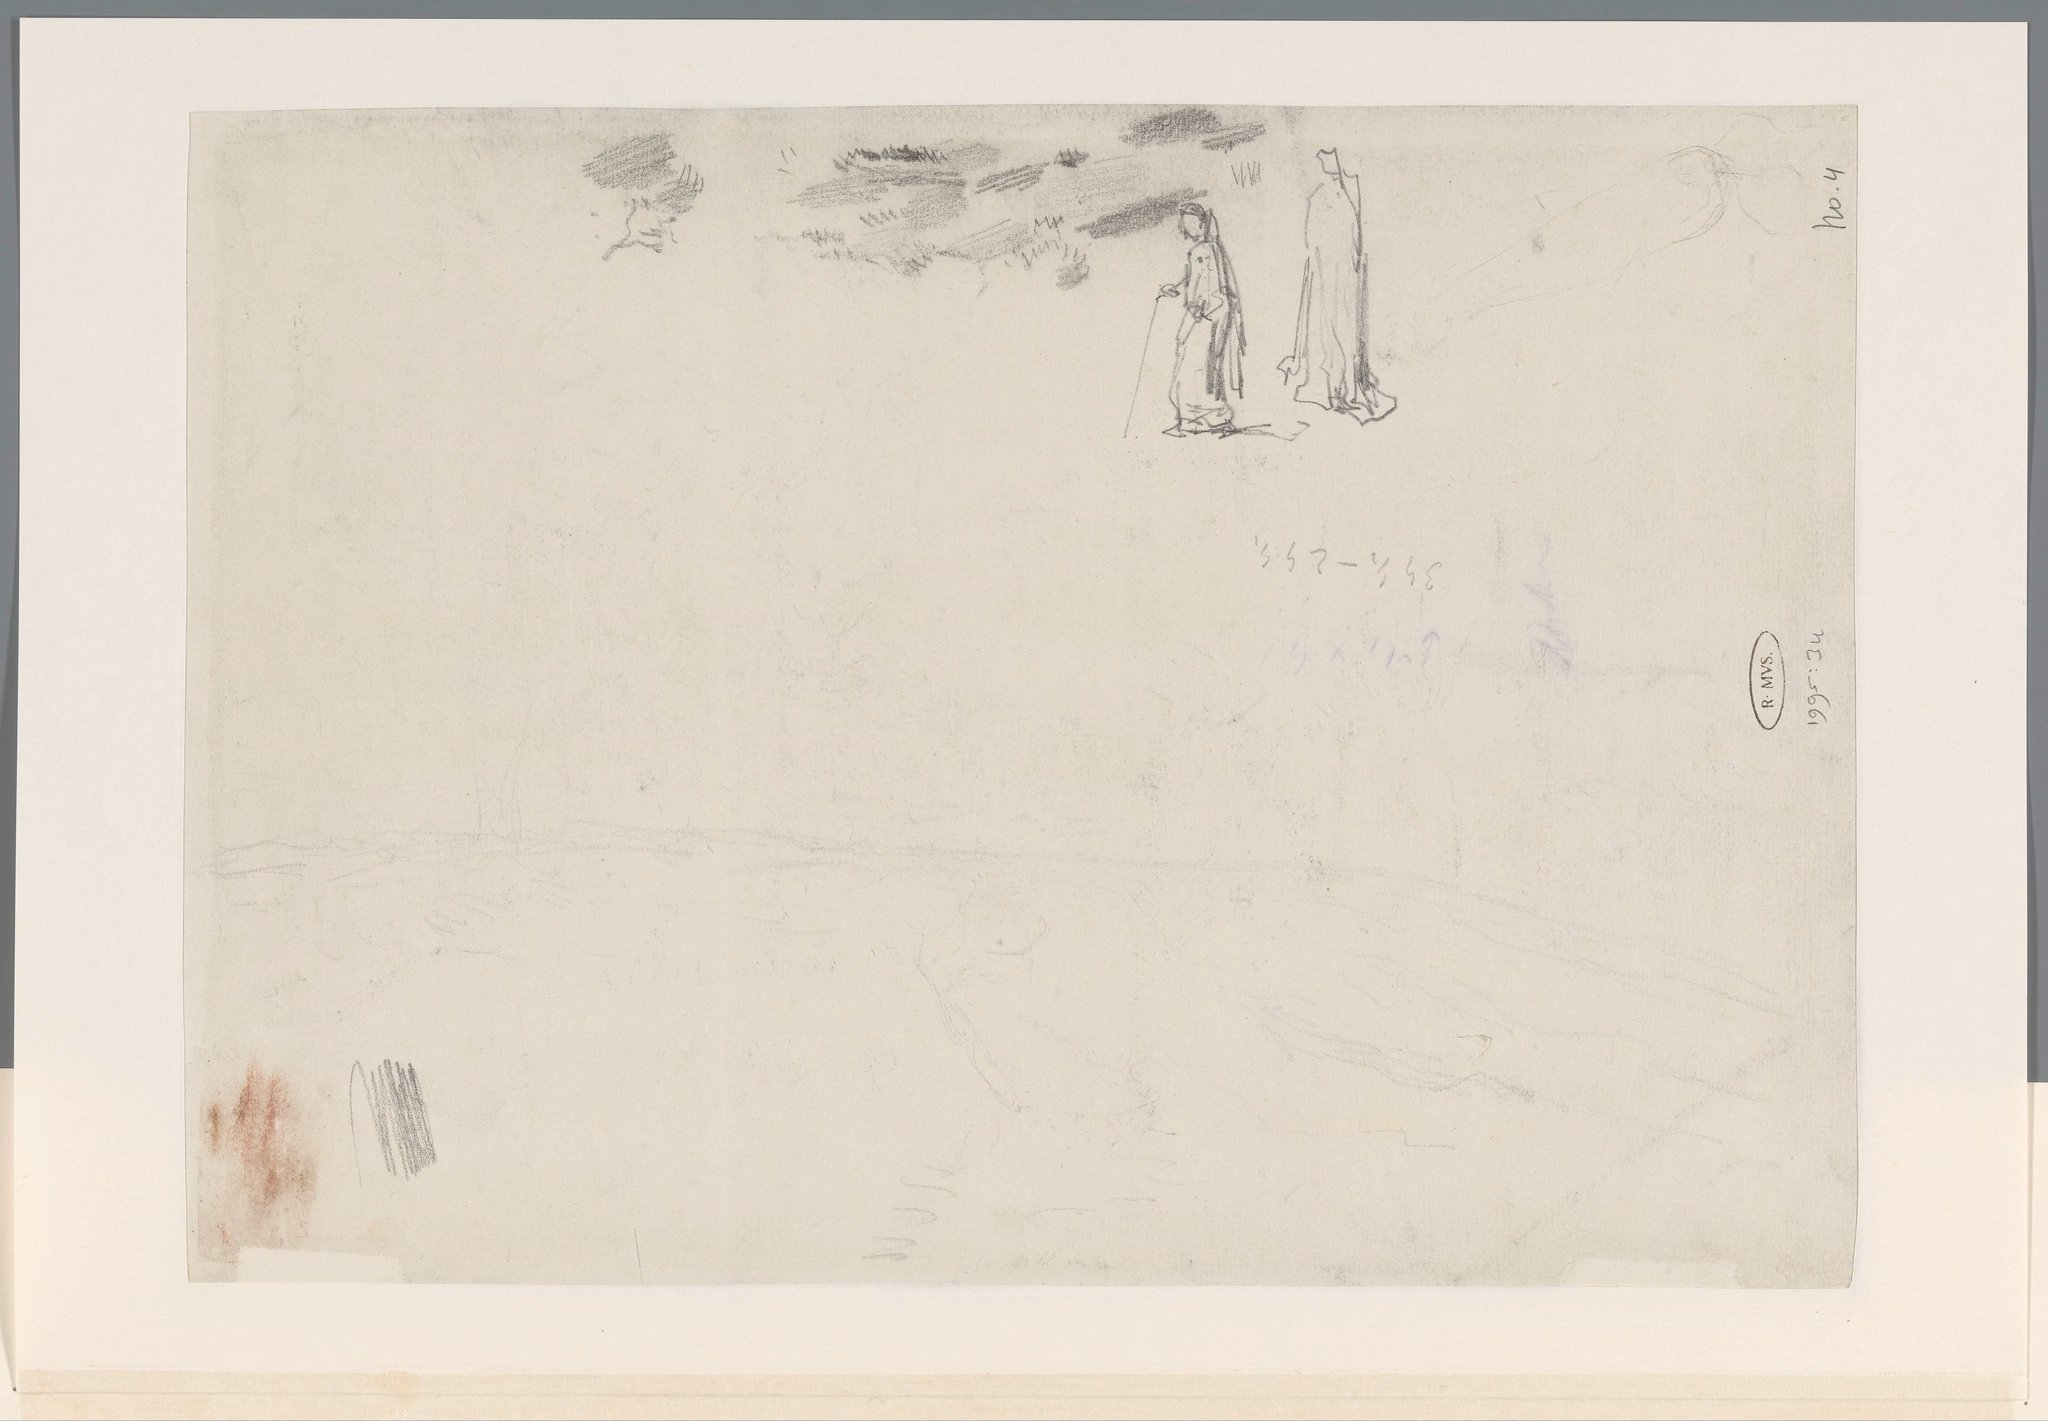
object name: drawing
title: Schets van twee figuren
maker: willem roelofs (i)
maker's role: draughtsman, painter, print maker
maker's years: 1822-1897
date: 1832-1897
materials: chalk, paper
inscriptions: inscription: ‘.’